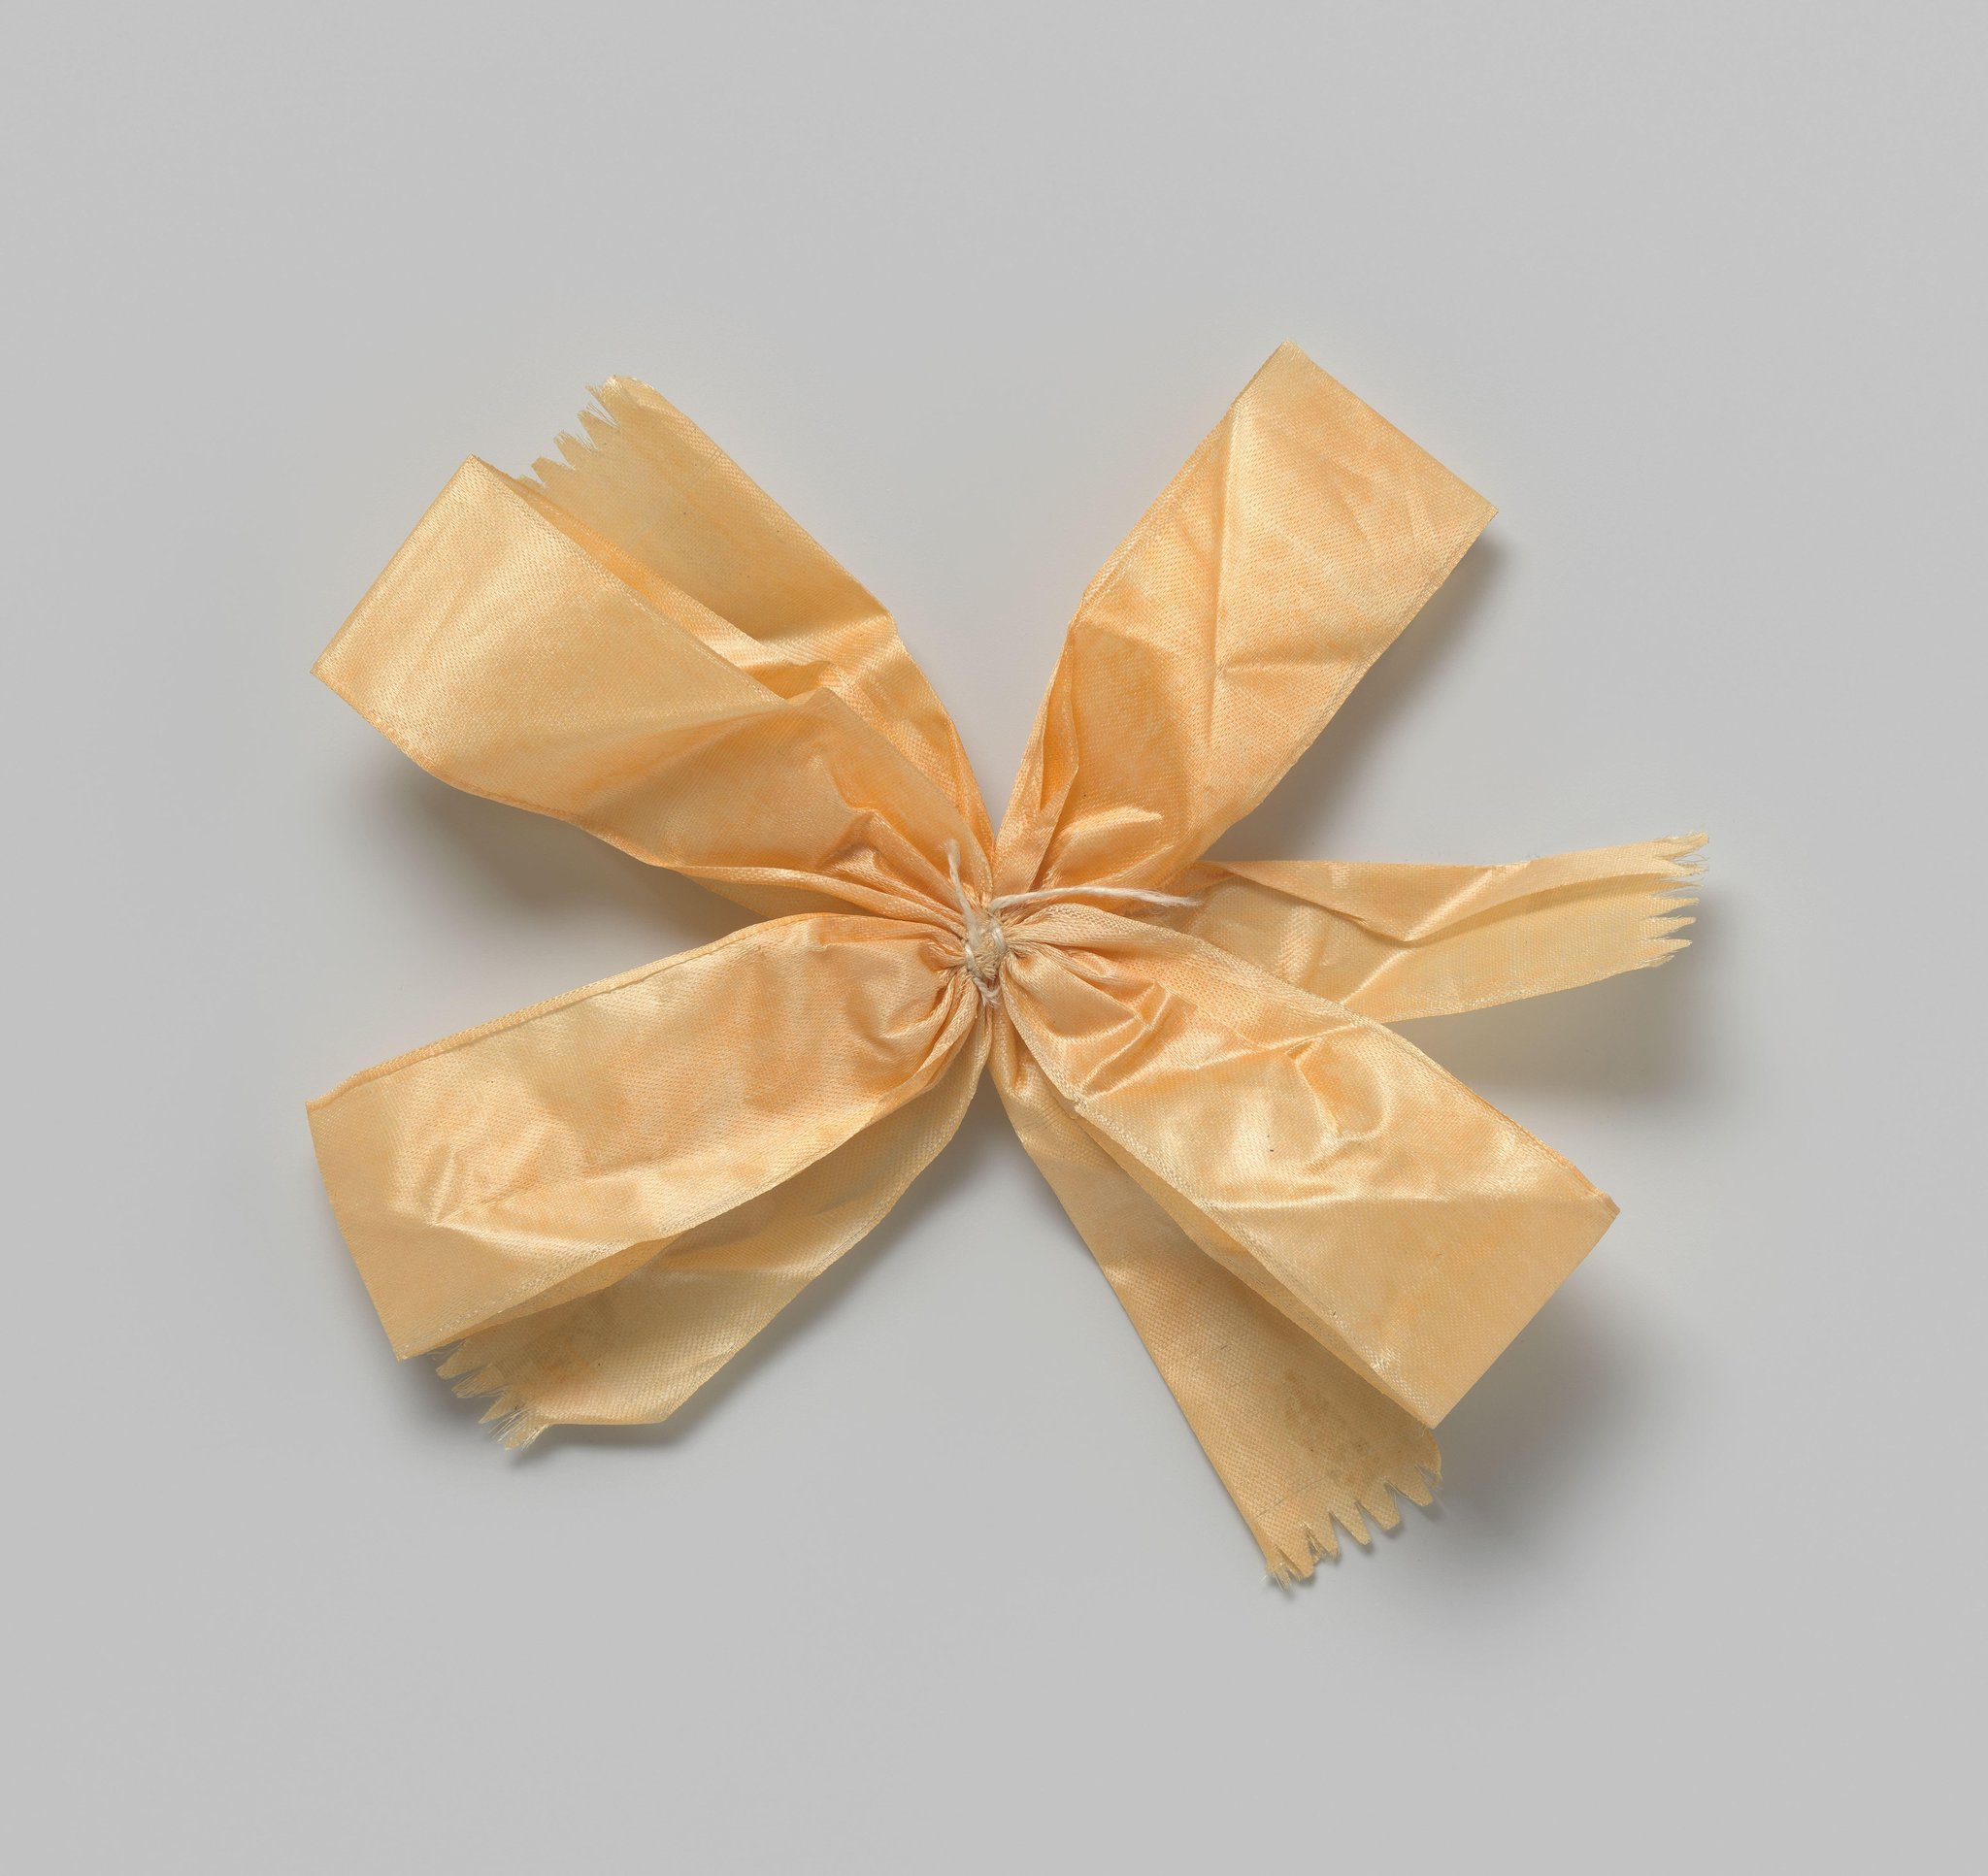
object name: work clothes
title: Hoedenstrik van smal oranje satijnlint, met vier lussen en vier gekartelde uiteinden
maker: Anonymous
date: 1700-1900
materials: textile, silk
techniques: snipping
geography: amsterdam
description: Hoedenstrik van smal oranje satijnlint, met vier lussen en vier gekartelde uiteinden